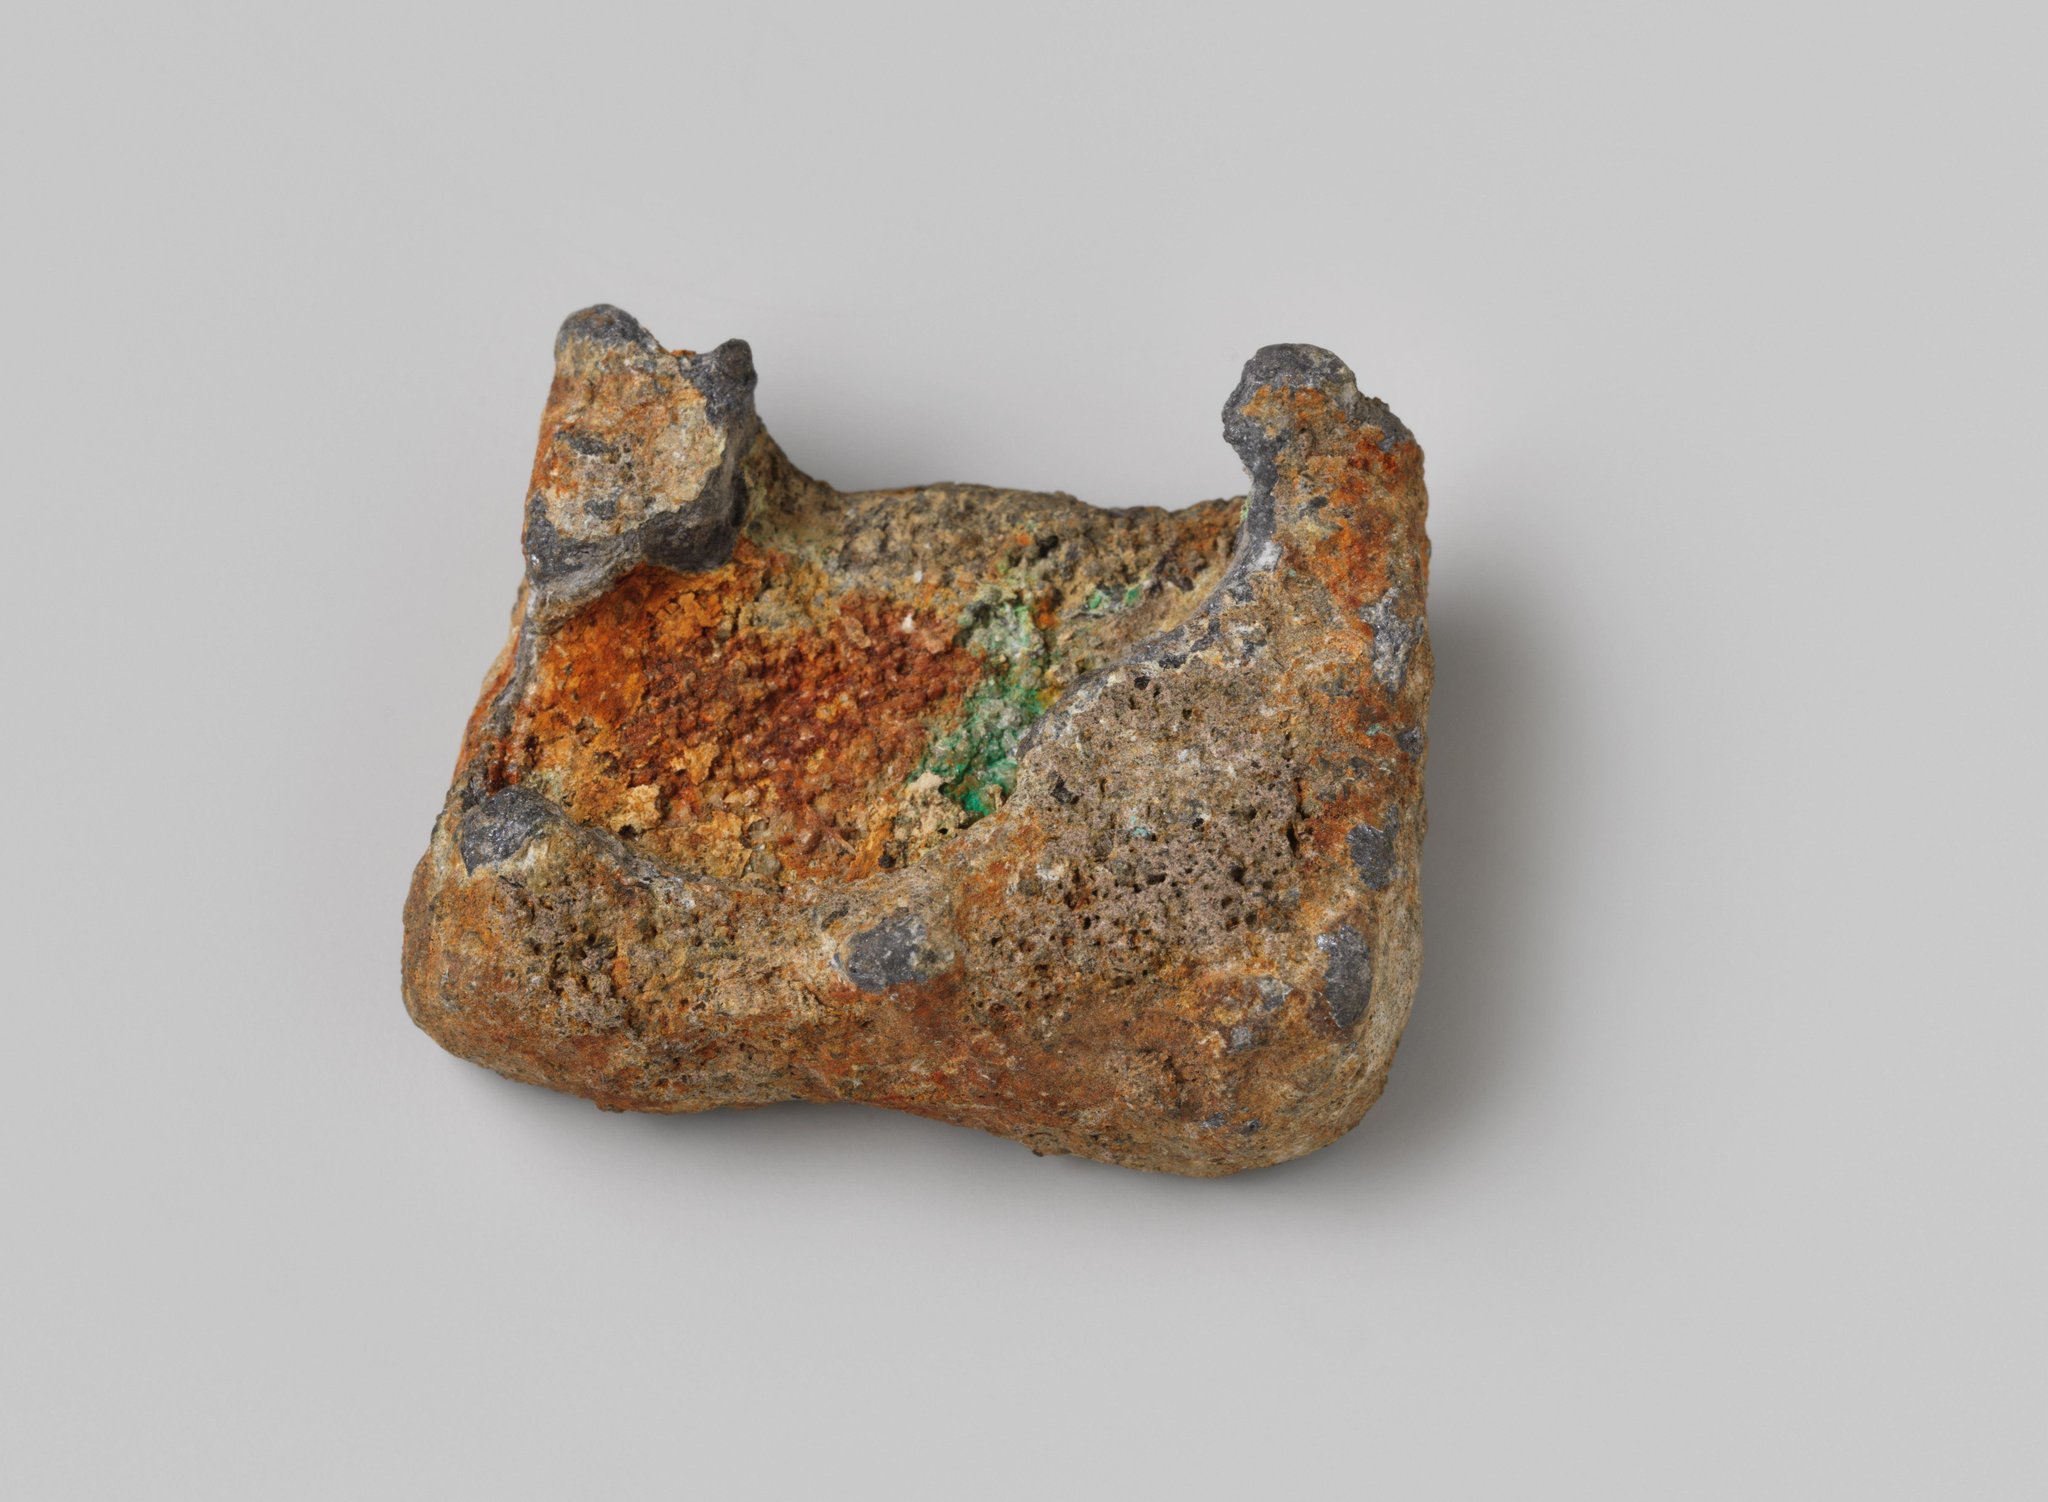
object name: fragment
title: Fragment van lood uit het wrak van de Oost-Indiëvaarder Hollandia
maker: Anonymous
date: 1700-1743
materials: lead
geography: netherlands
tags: verenigde oostindische compagnie, hollandia (schip), annet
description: Varied parts or fragments, unidentified and miscellaneous parts or fragments; fragm.